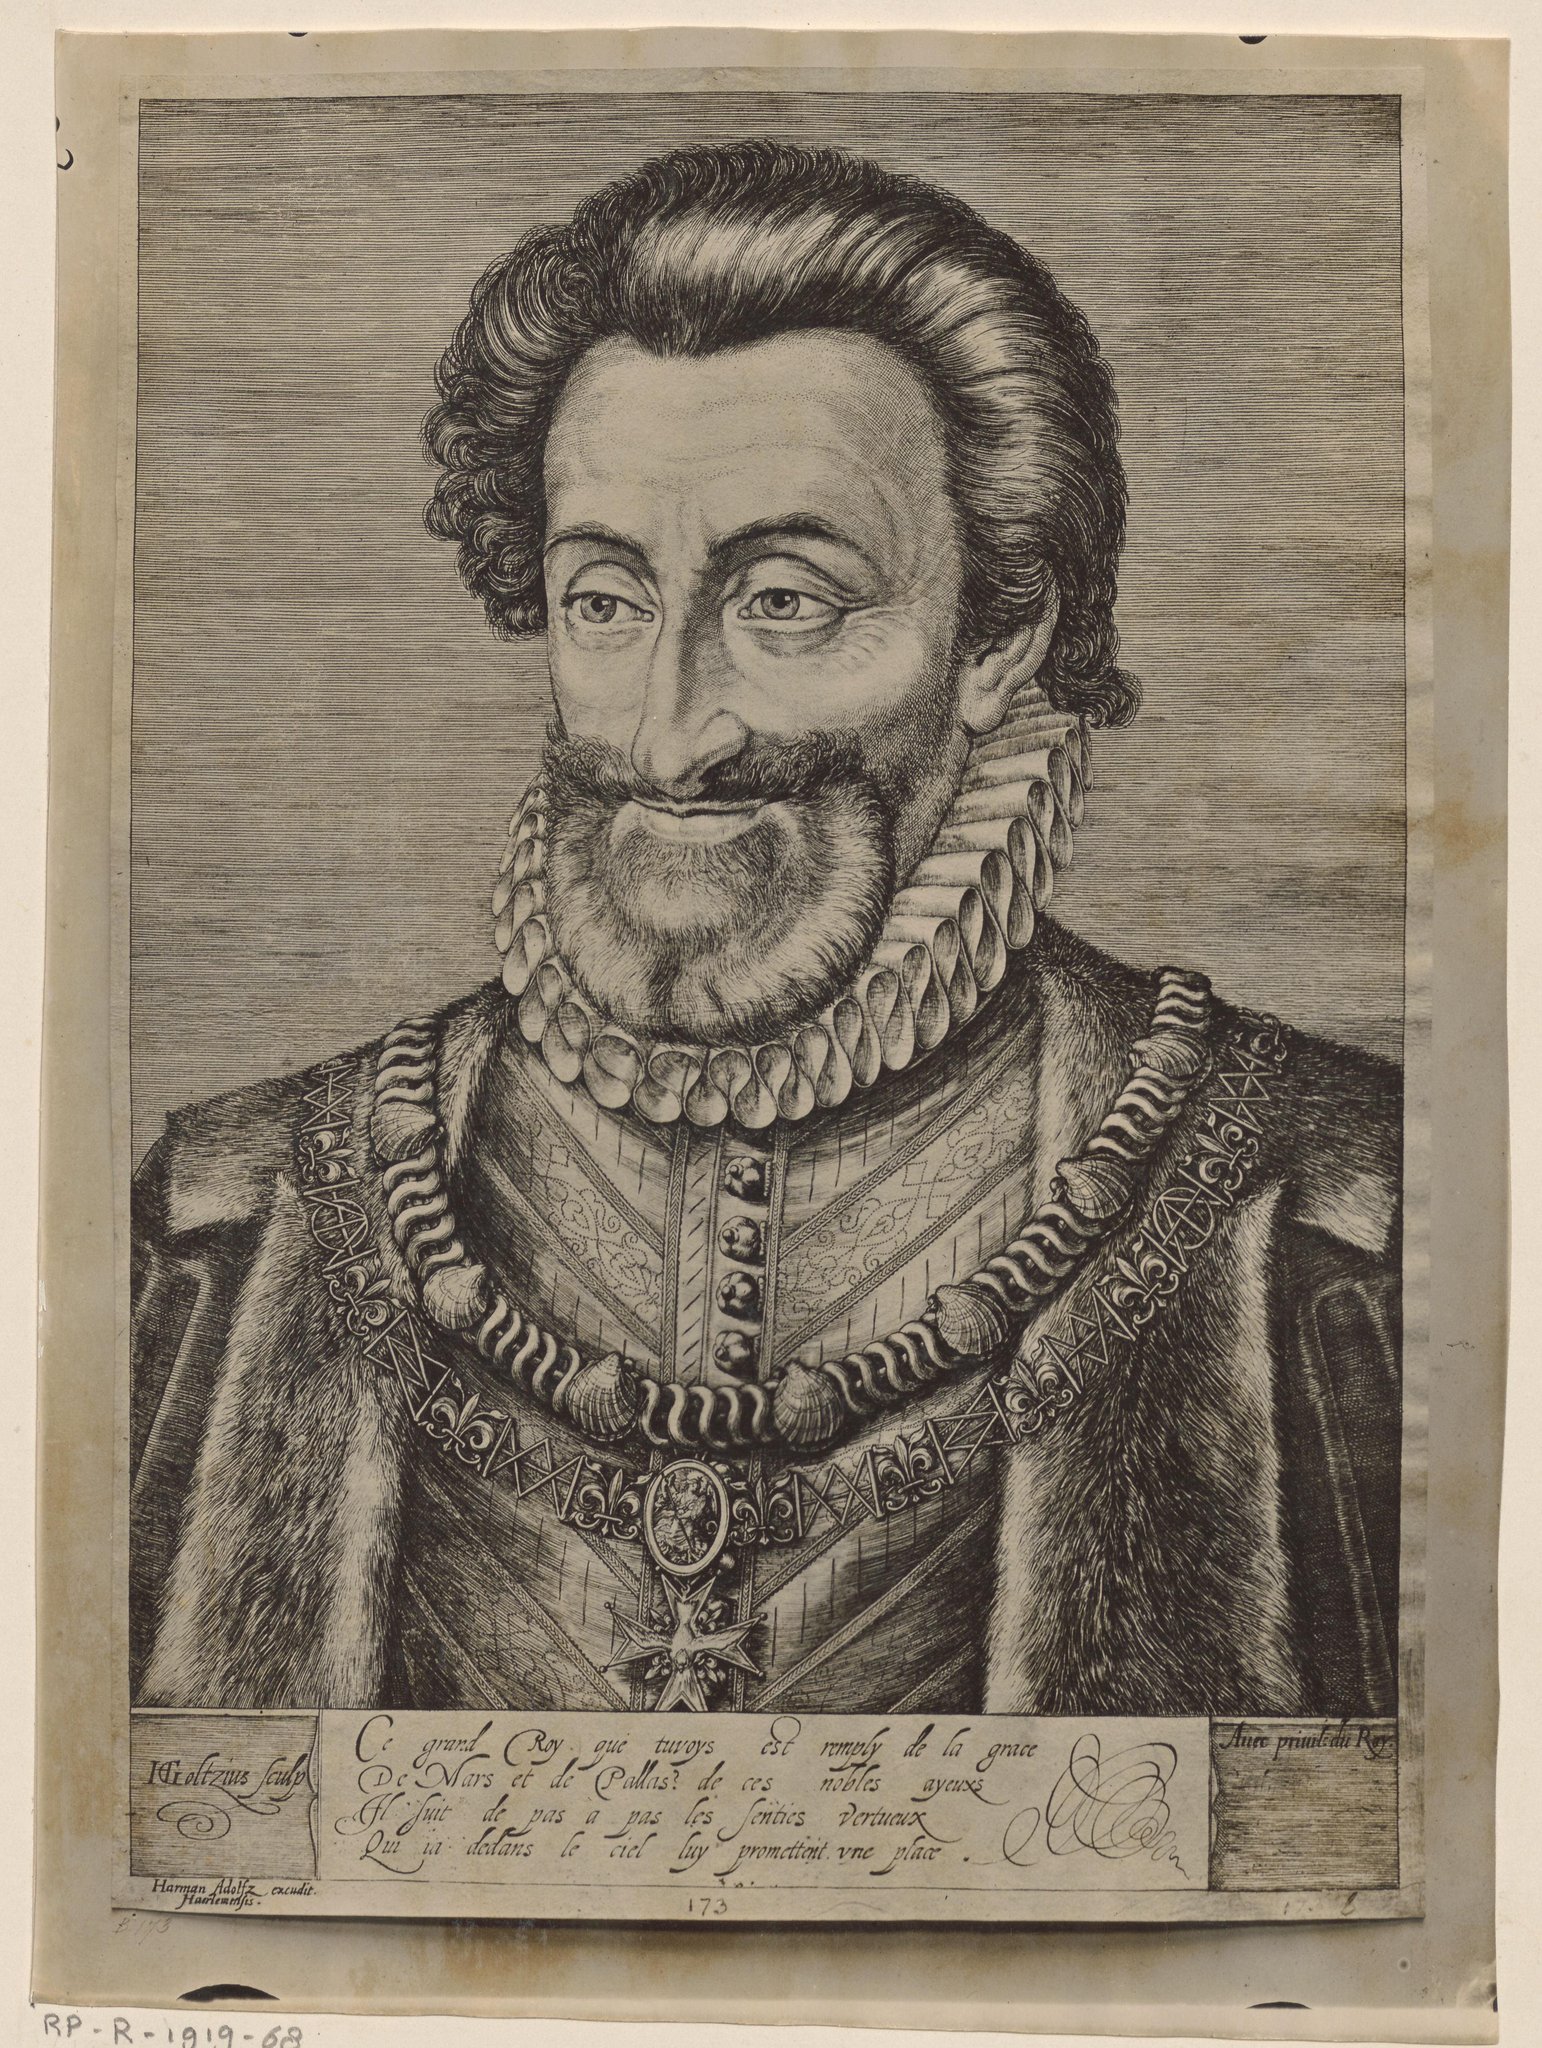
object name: photograph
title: Portret van Hendrik IV, koning van Frankrijk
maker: cornelis johannes steenbergh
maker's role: fotograaf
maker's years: 1859-1939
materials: paper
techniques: gelatin silver print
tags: hendrik iv (koning van frankrijk en navarra), historical persons, king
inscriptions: inscription: ‘H. Goltzius. H 193/ Steenbergh’